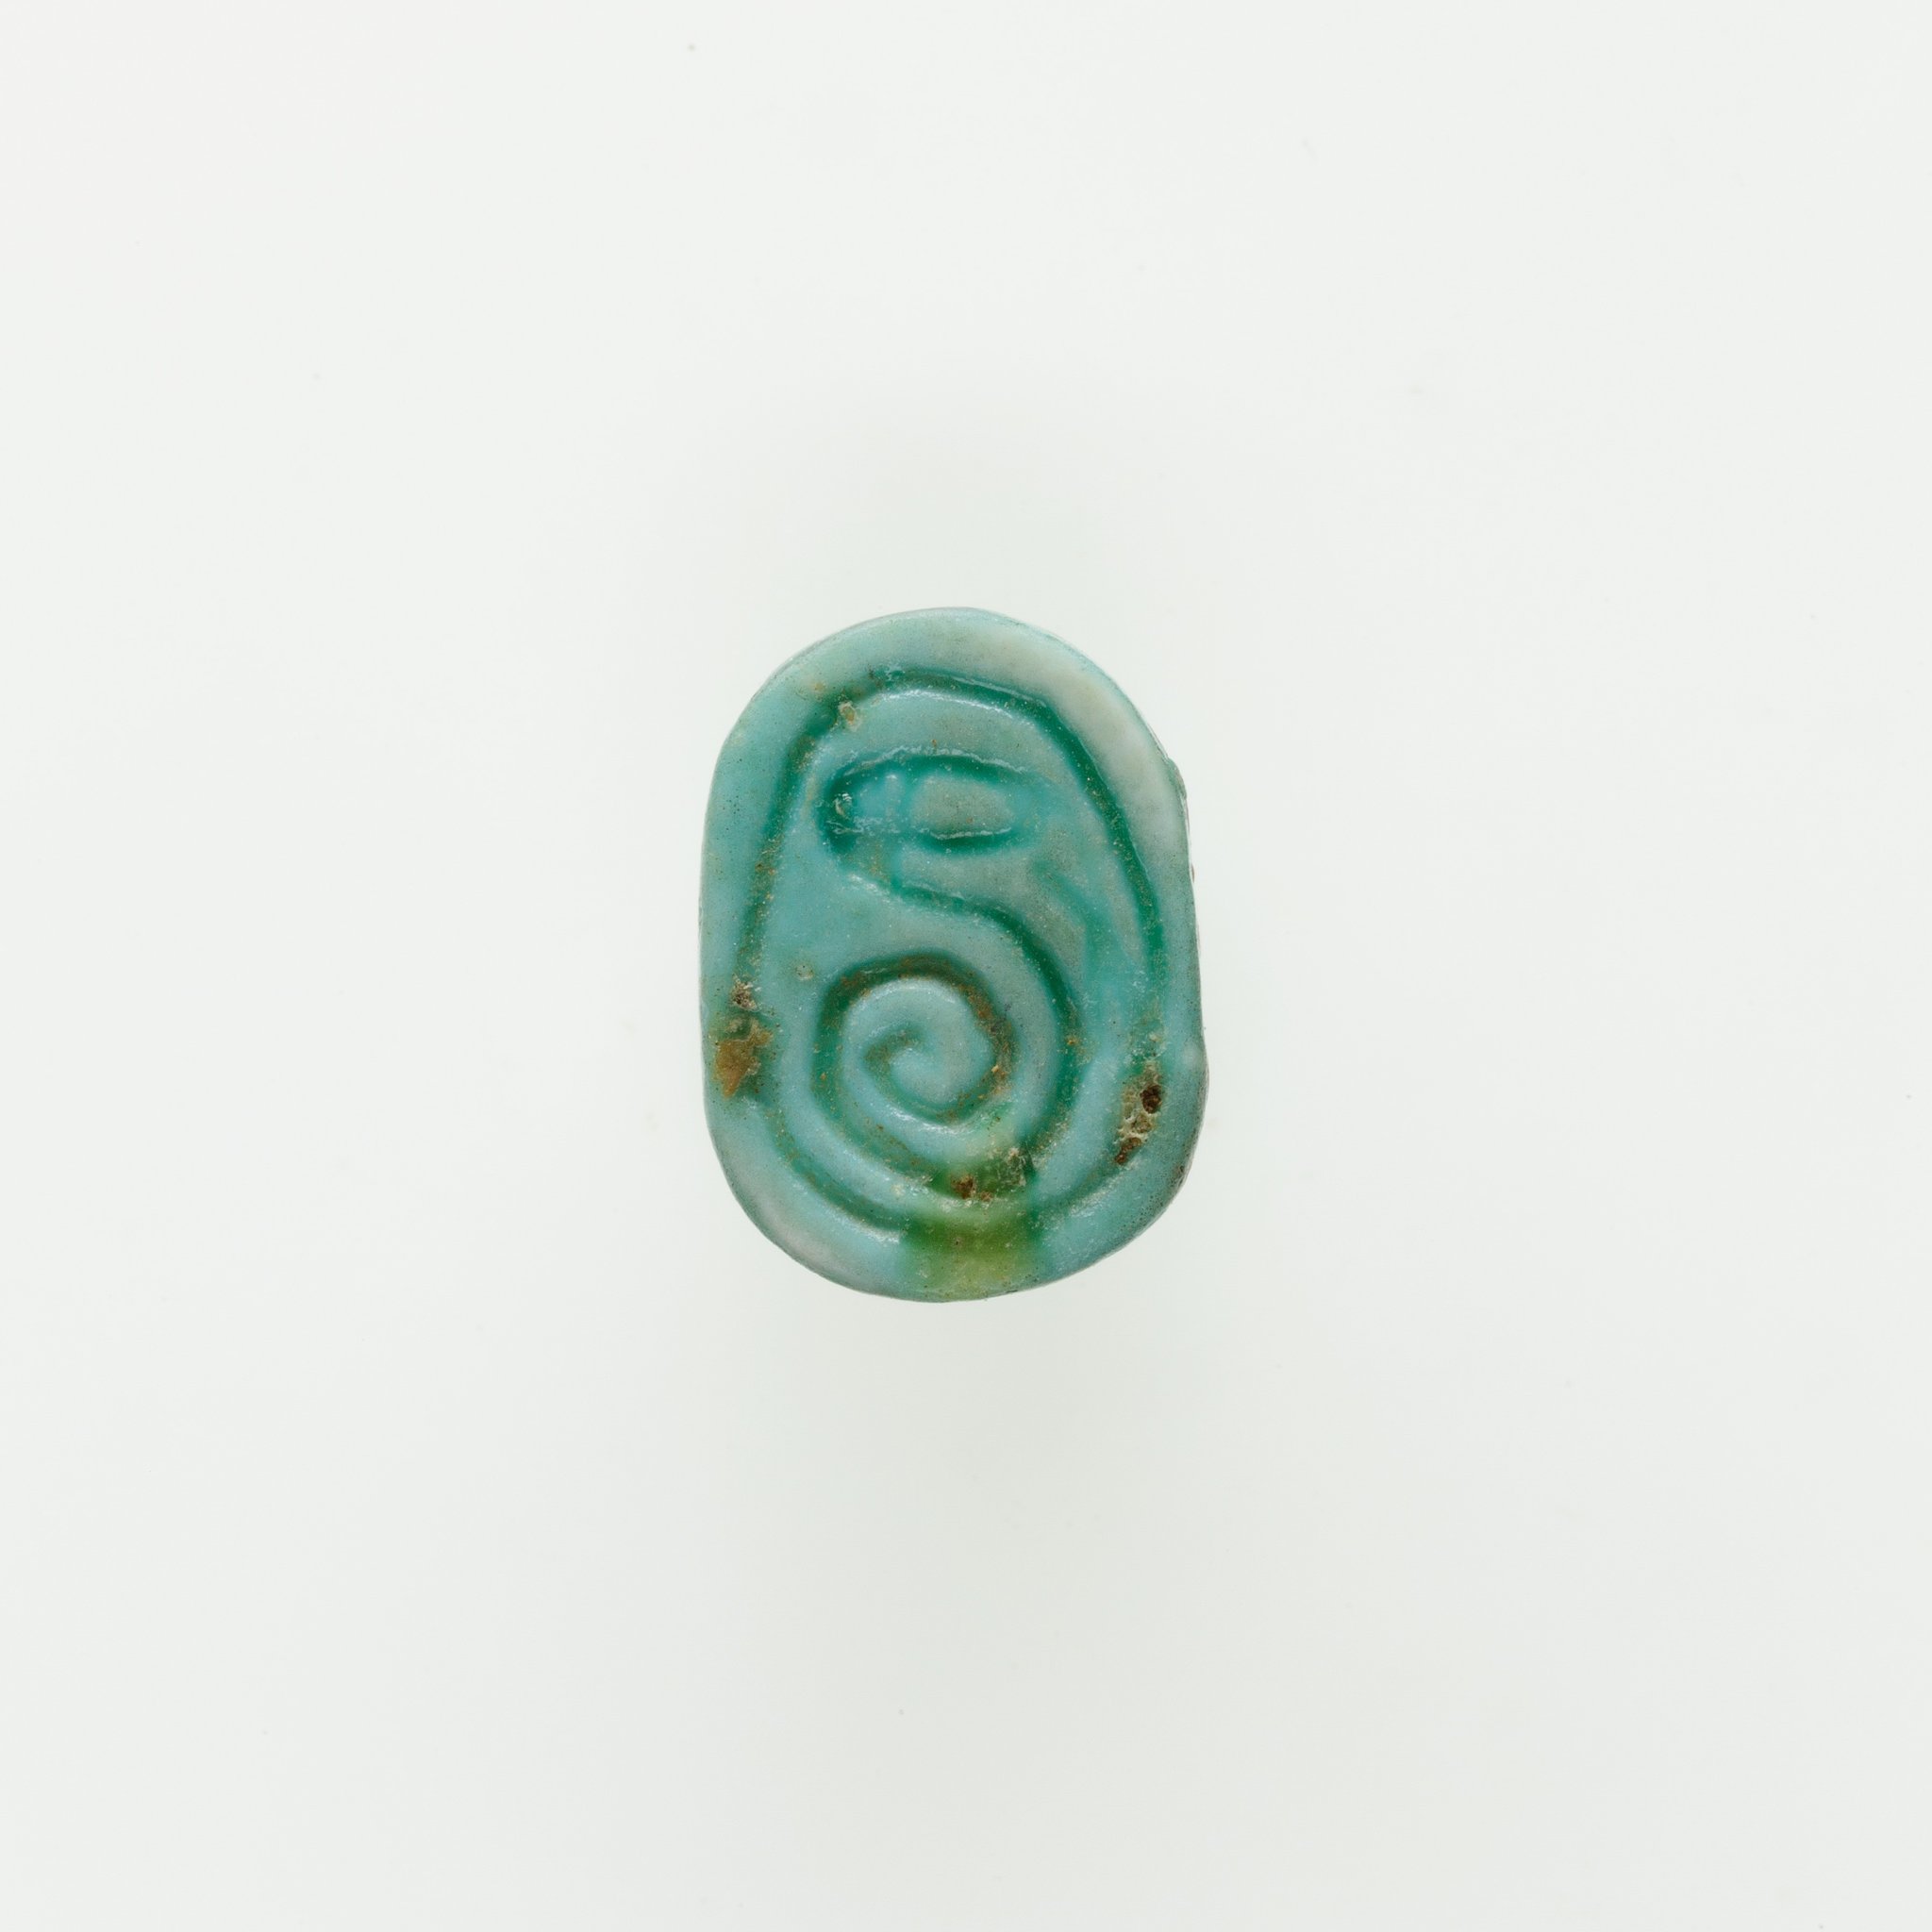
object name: scarab, spiral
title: Scarabs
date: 1492-1473 BCE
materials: stone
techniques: glazing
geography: egypt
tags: scarabs